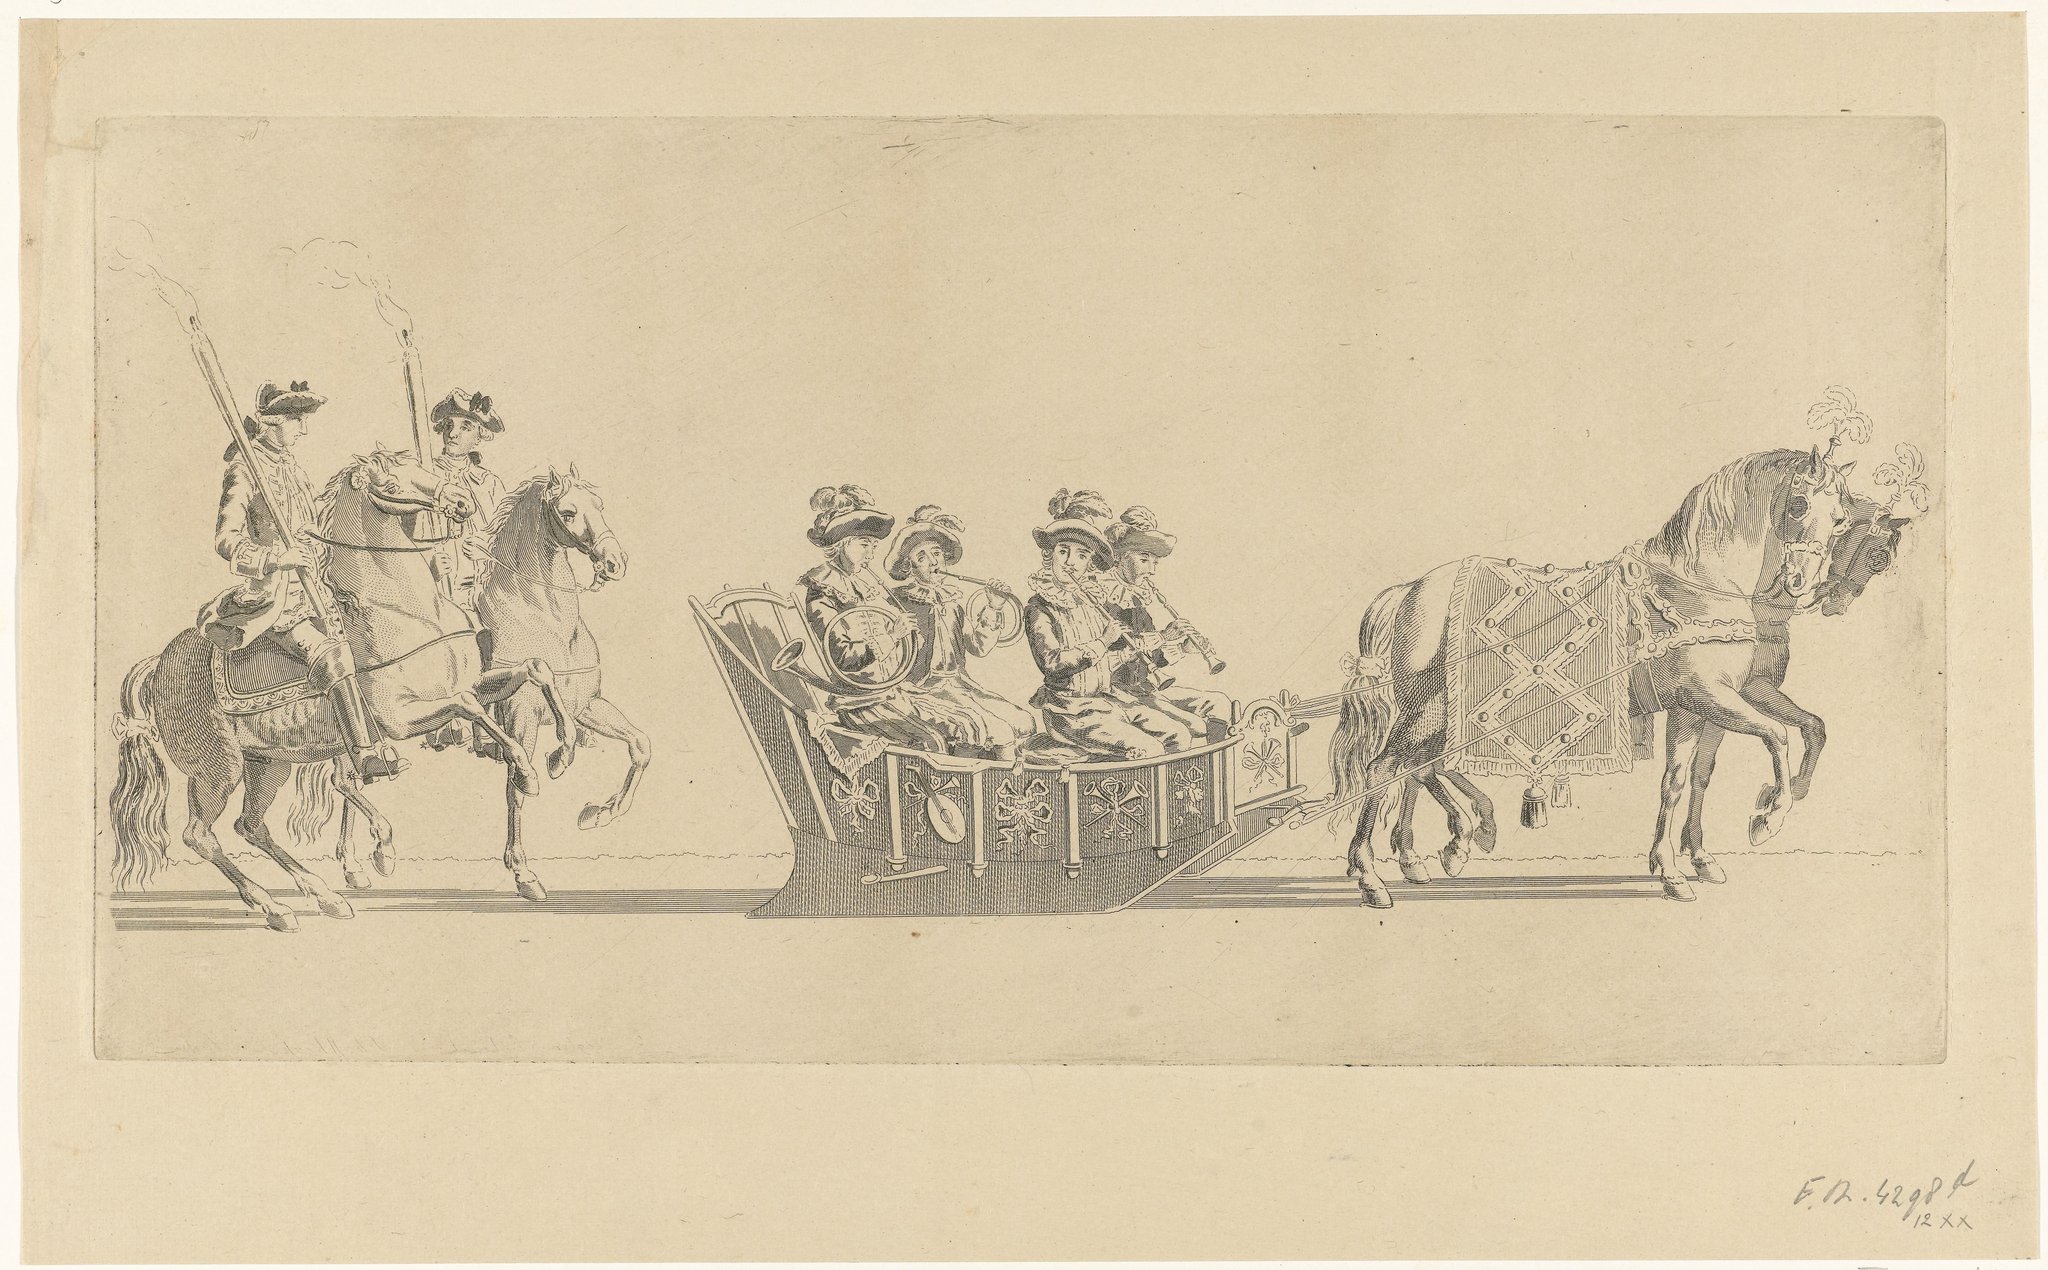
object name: print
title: Sledevaart van het Leidse genootschap Veniam Pro Laude in 1776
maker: nicolaas van der worm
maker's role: draughtsman, print maker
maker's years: 1757-1828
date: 1776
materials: paper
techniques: etching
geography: northern netherlands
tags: sledge, sleigh (winter sports), commemoration of the founding of a university, leiden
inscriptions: collector's mark: Lugt 240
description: De twaalfde slede in de optocht. Een slede met vier muzikanten, getrokken door een paard, gevolgd door twee ruiters met toortsen. Onderdeel van een reeks van twaalf platen (etsdruk vóór het nummer en op ander papier) van de sledevaart op 24 januari 1776 georganiseerd door het Leidse genootschap Veniam Pro Laude bij gelegenheid van het Tweede Eeuwfeest van het Leids Ontzet (3 oktober 1574) en de oprichting van de Universiteit van Leiden (8 februari 1575).